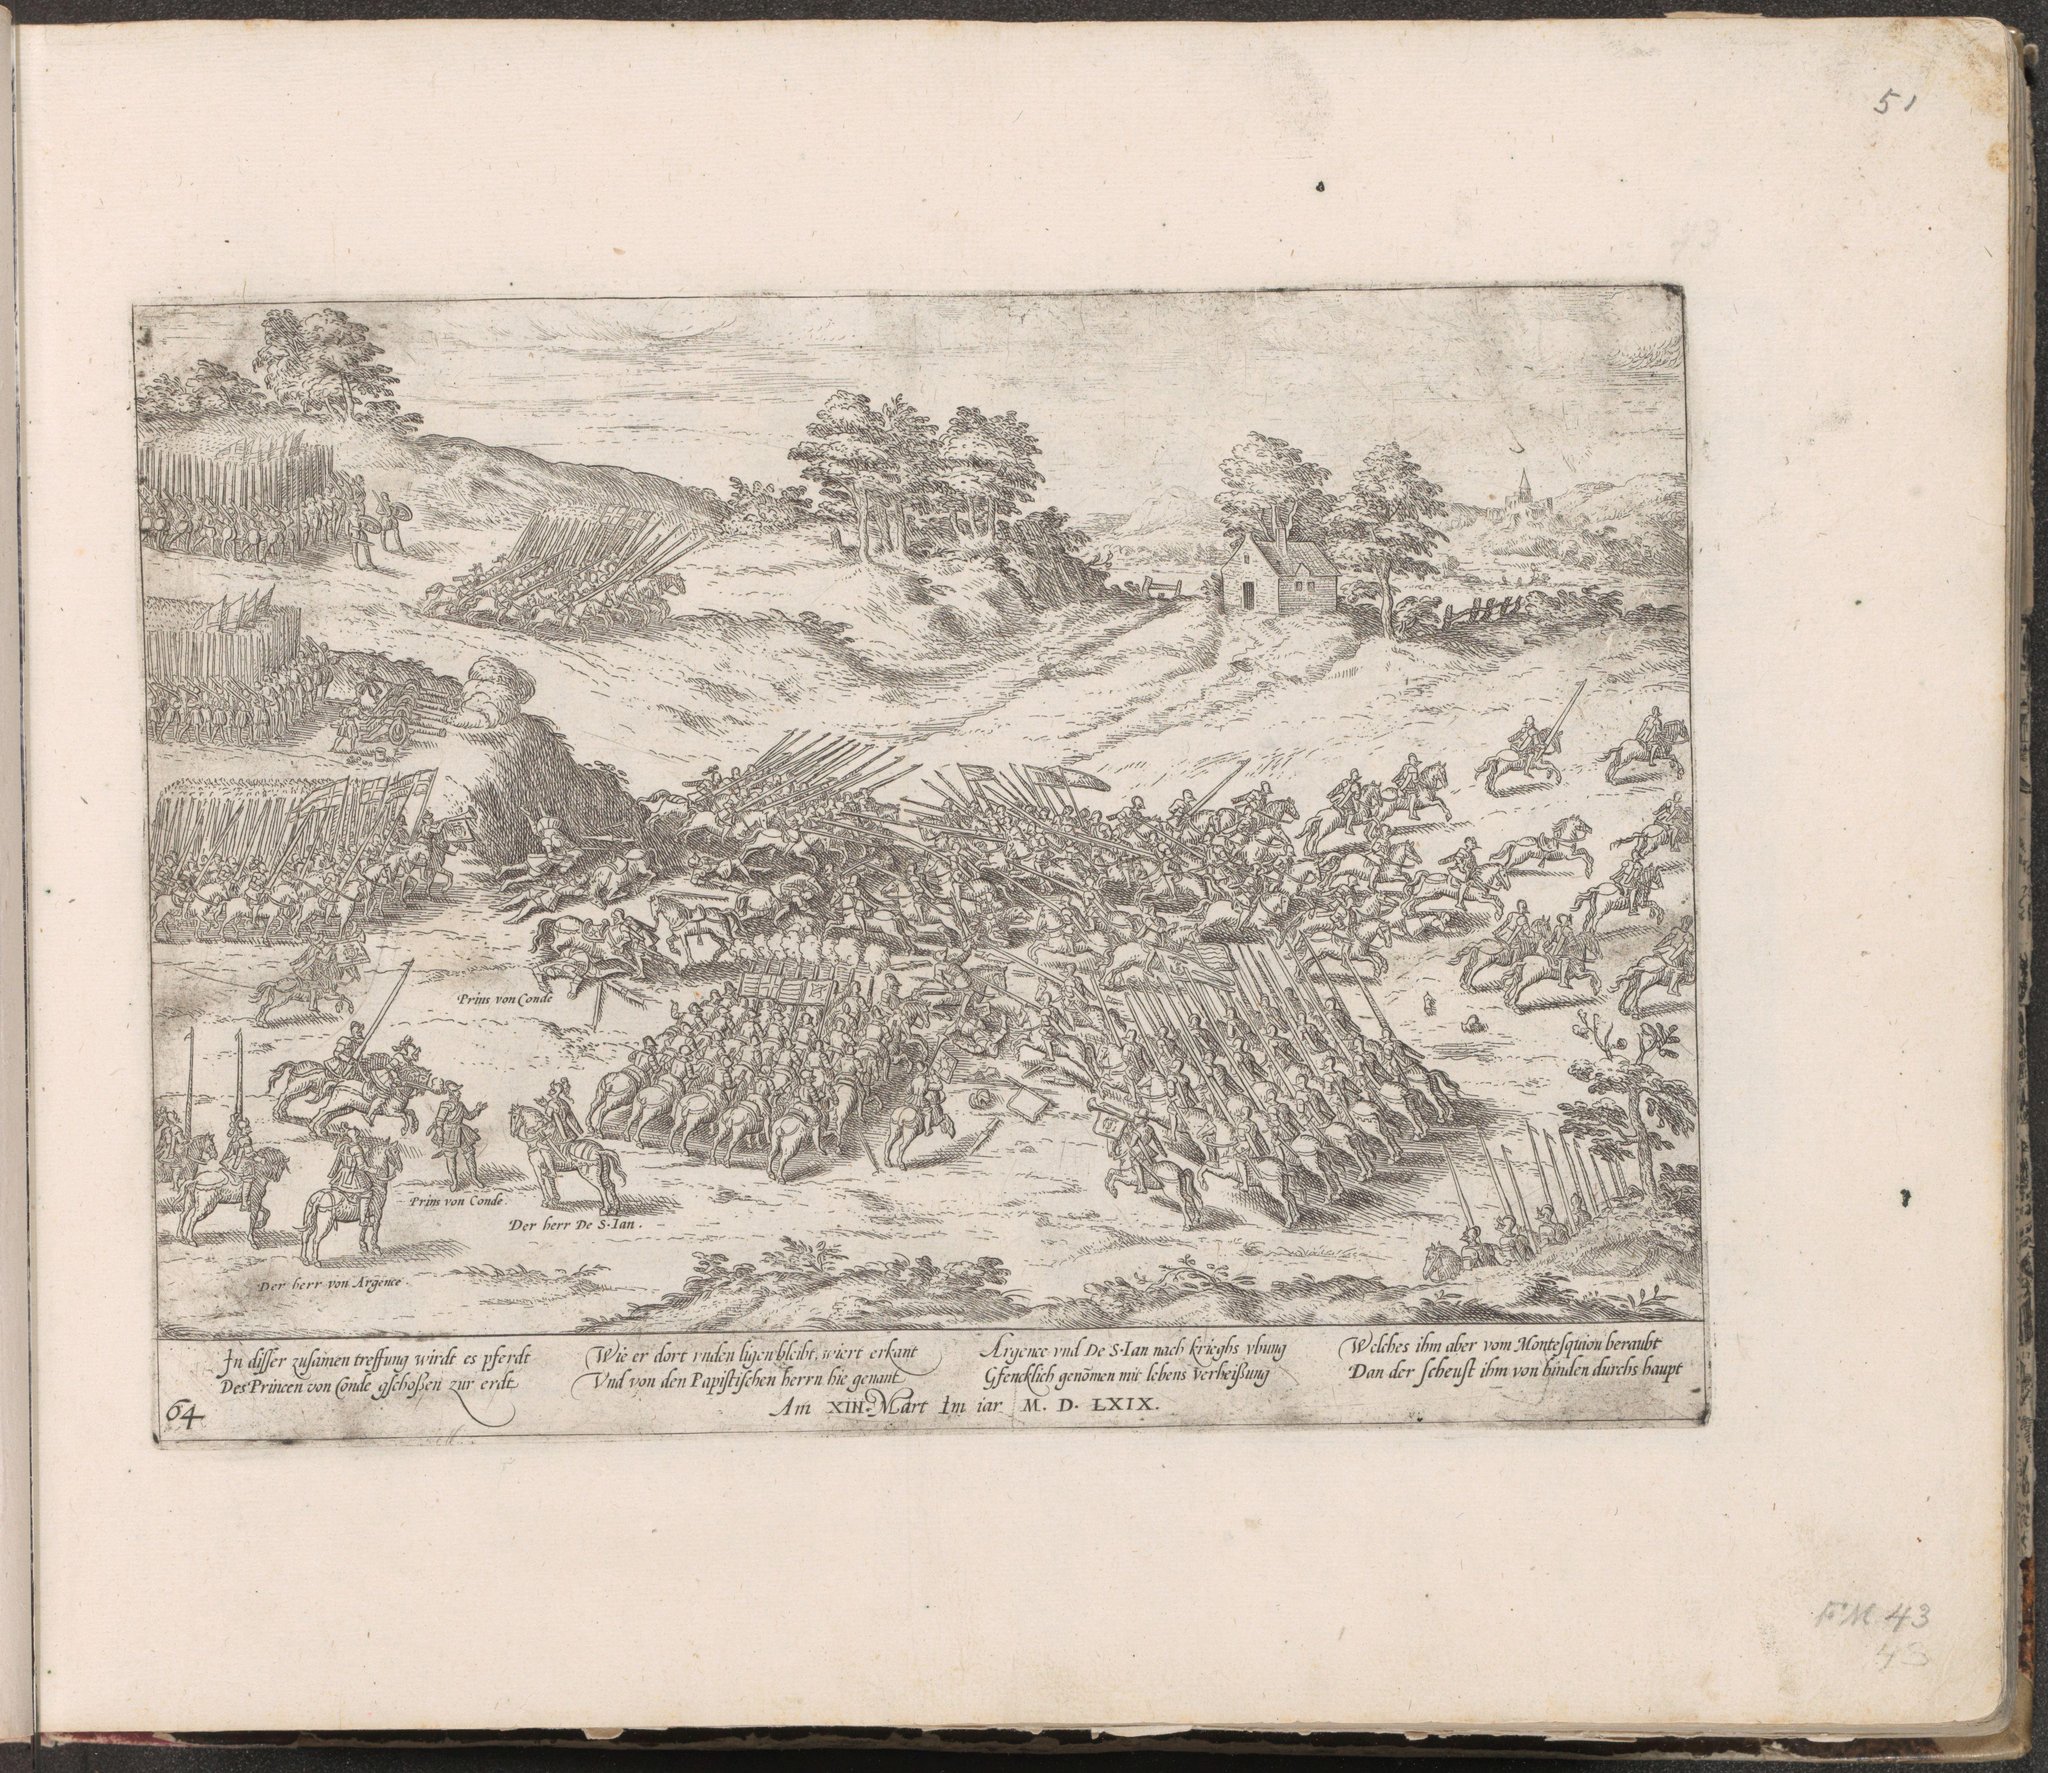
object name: album leaf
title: Serie 3: Franse Godsdienstoorlogen, 1559-1573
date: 1569-1571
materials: paper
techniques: etching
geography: cologne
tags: violent death, being killed; being mishandled and maltreated; seeking death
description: Prins van Condé gevangengenomen en vermoord tijdens de slag bij Jarnac, 13 maart 1569. Gezicht op het slagveld. Met onderschrift van 8 regels in het Duits. Linksonder genummerd: 64. De prent maakt deel uit van een album.